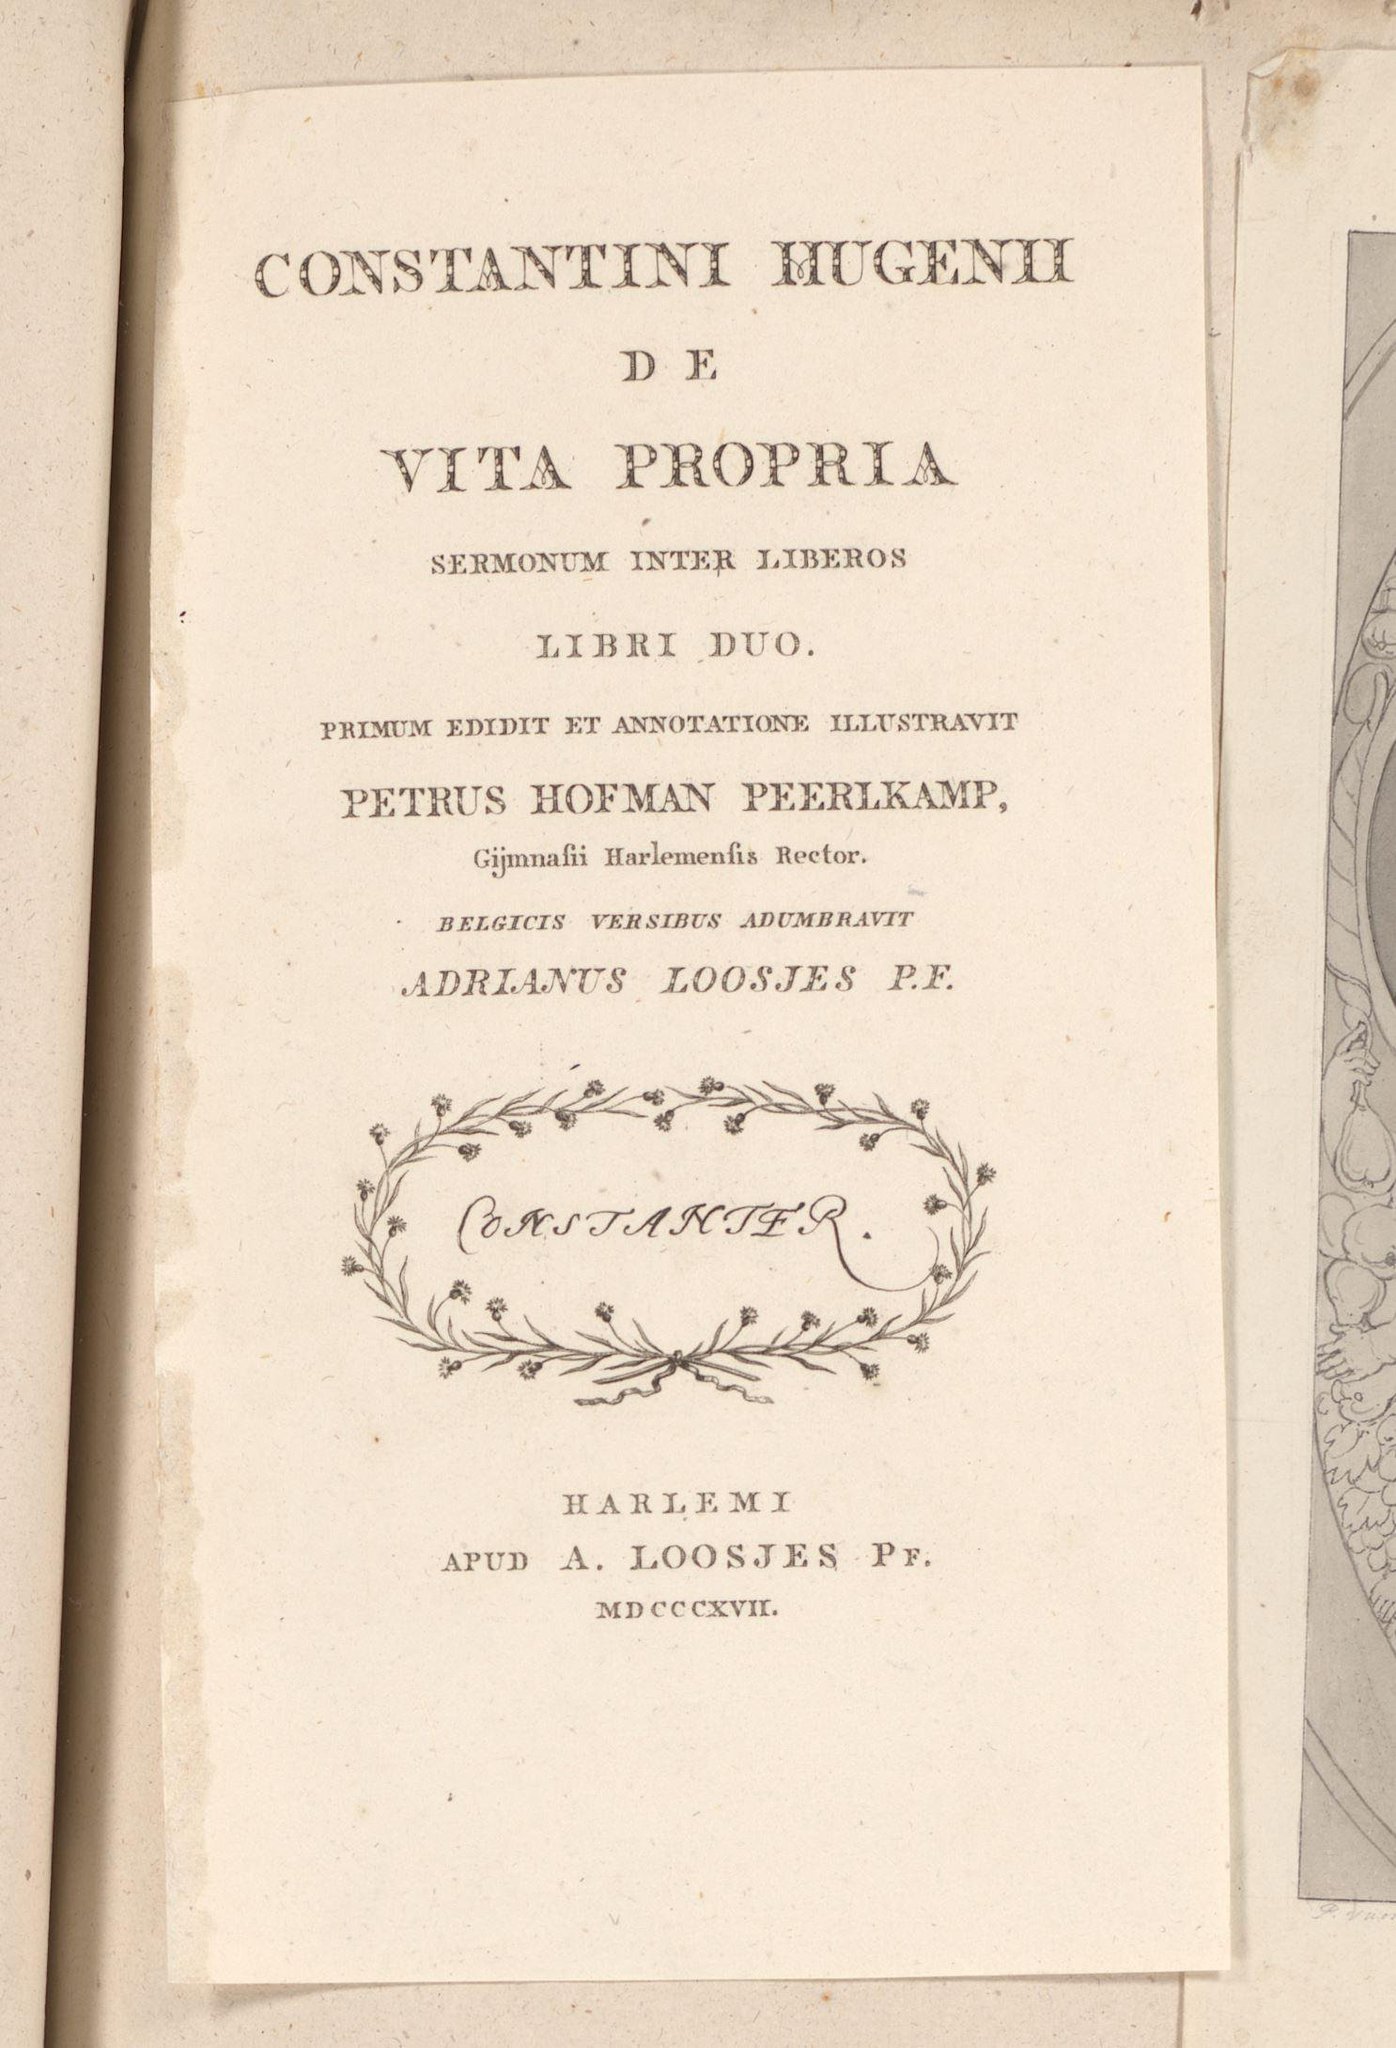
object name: titelblad, titelpagina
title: Bloemenkrans met 'Constanter'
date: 1817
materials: paper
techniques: engraving, etching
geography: haarlem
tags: the hague, constantijn huygens (i), title-page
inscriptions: date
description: Gebruikt als titelpagina voor: Constantini Hugenii De vita propria, sermonum inter liberos libri duo. Primum editit et annotatione illustravit Petrus Hofman Peerlkamp; belgicis versibus adumbravit Adrianus Loosjes. Haarlem: A. Loosjes, 1817.